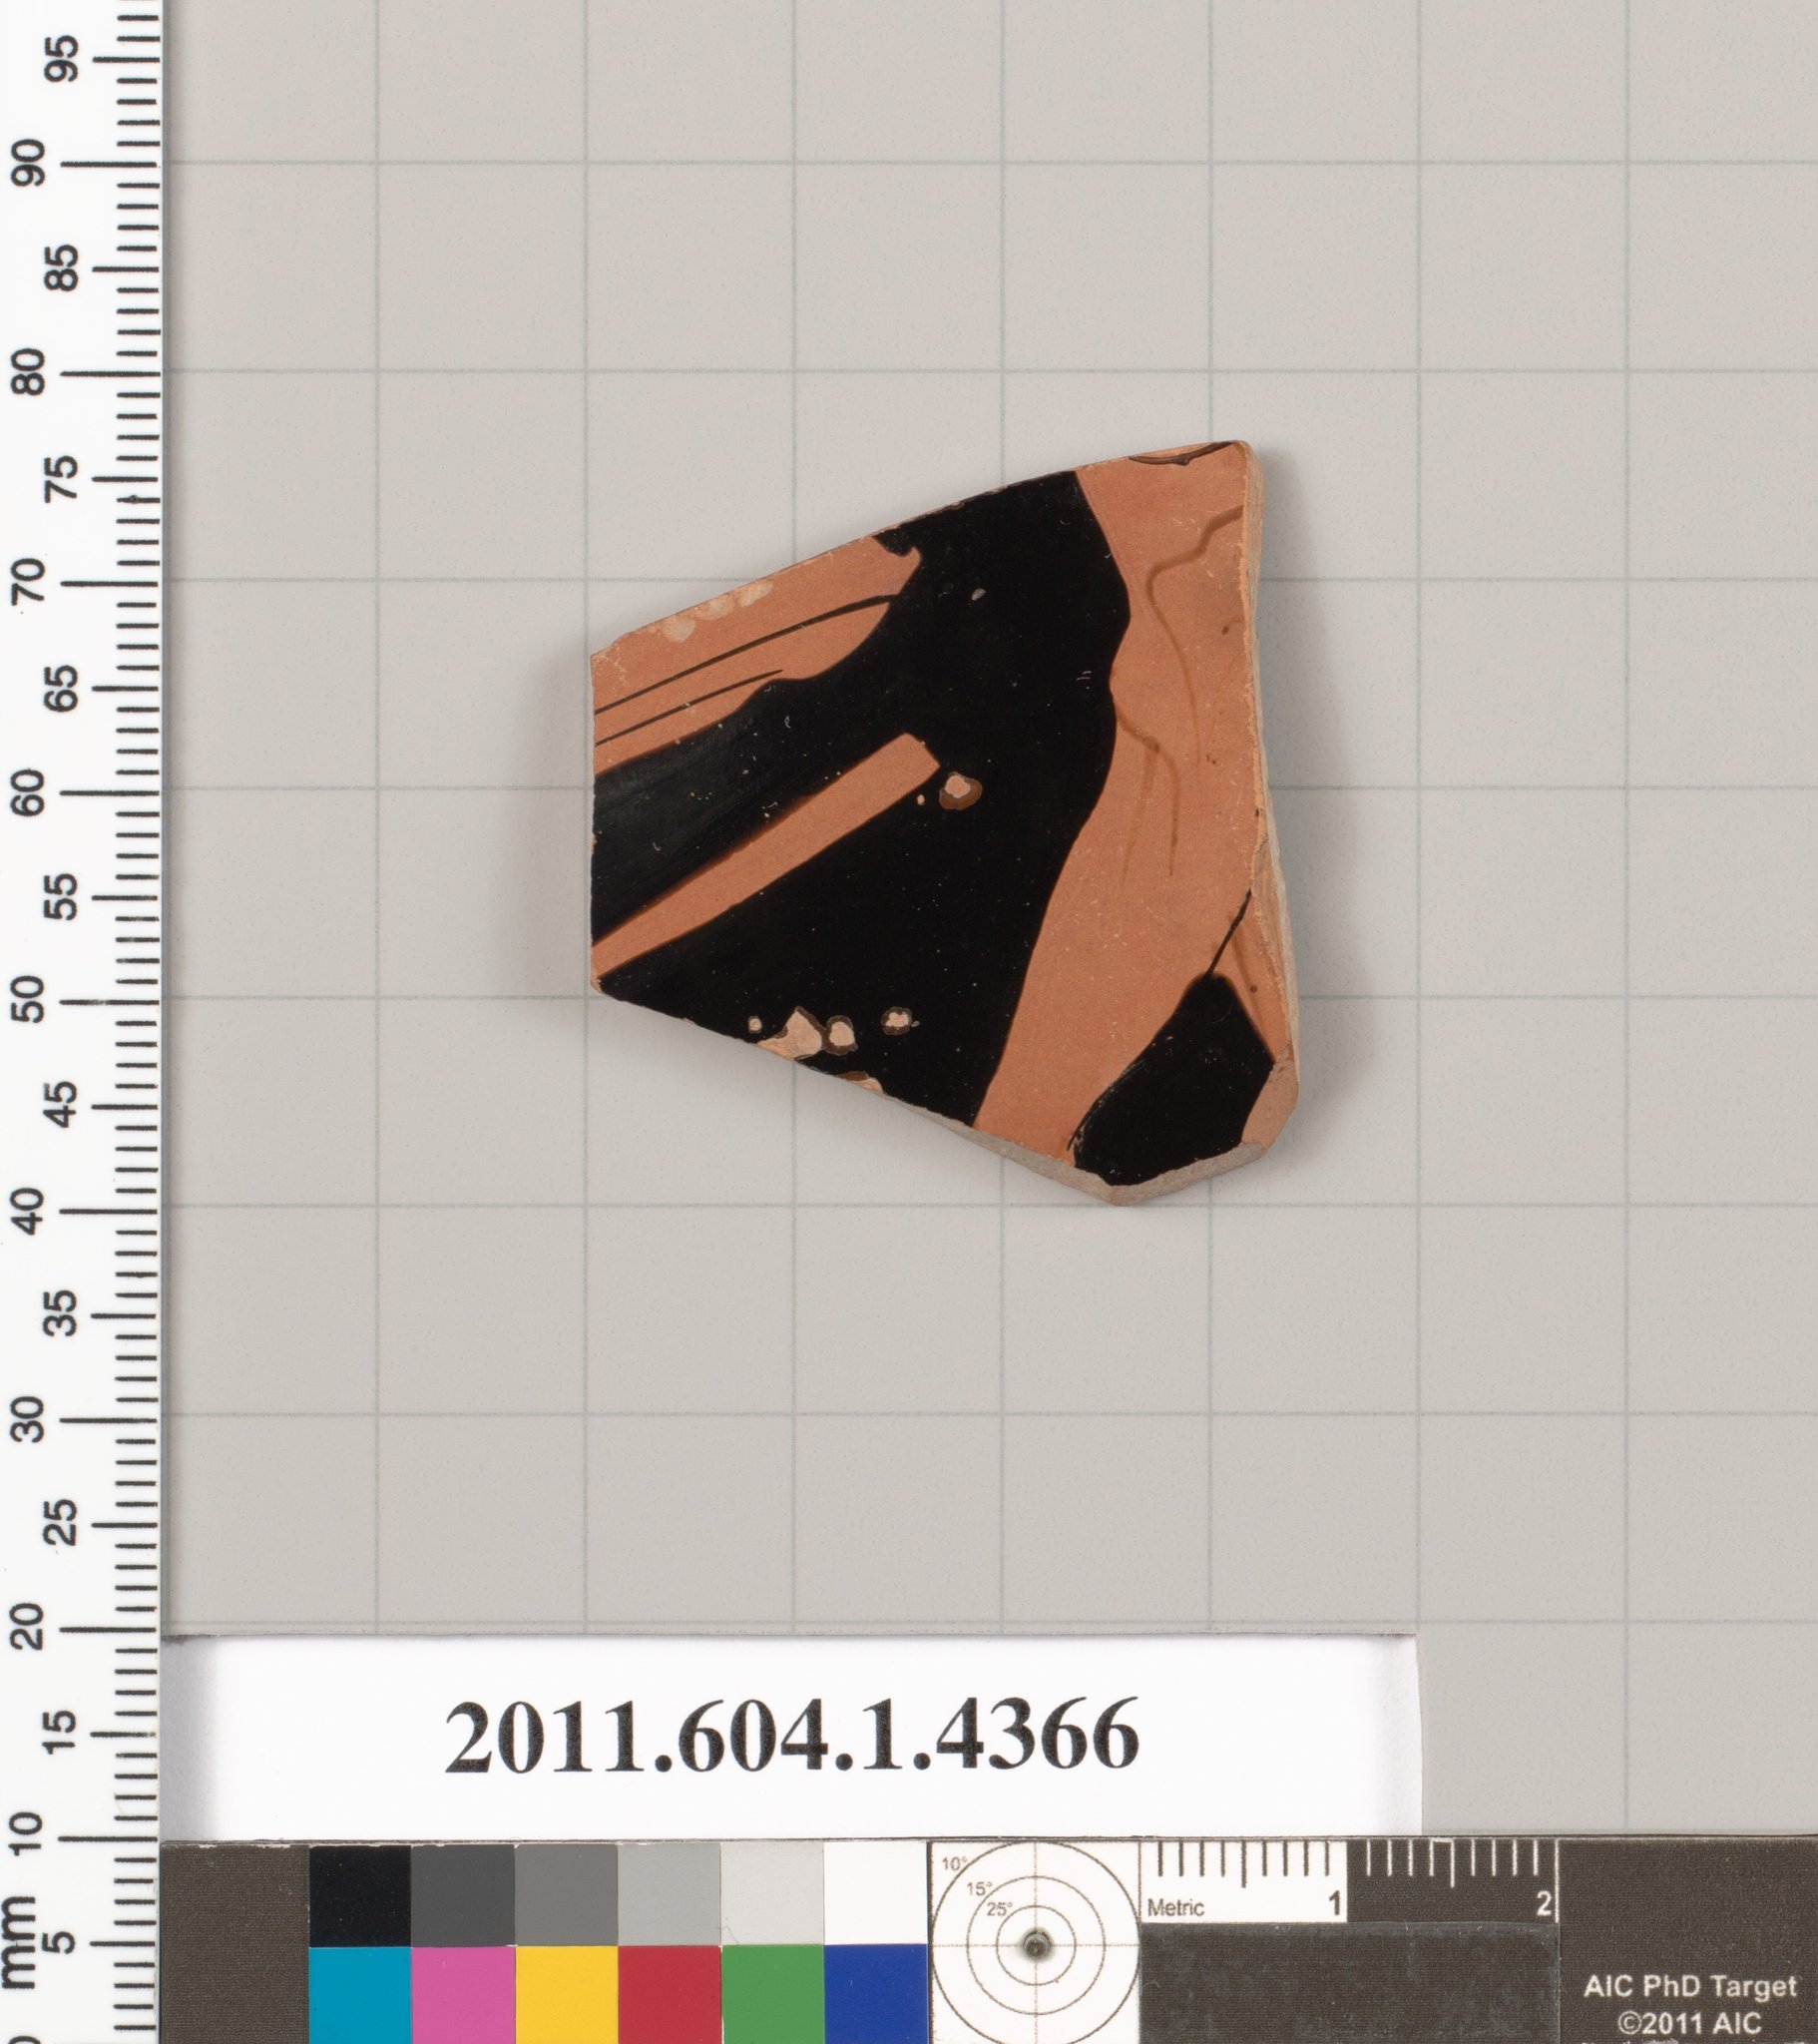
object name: kylix fragment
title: Terracotta fragment of a kylix (drinking cup)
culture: greek, attic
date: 467-435 BCE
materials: terracotta